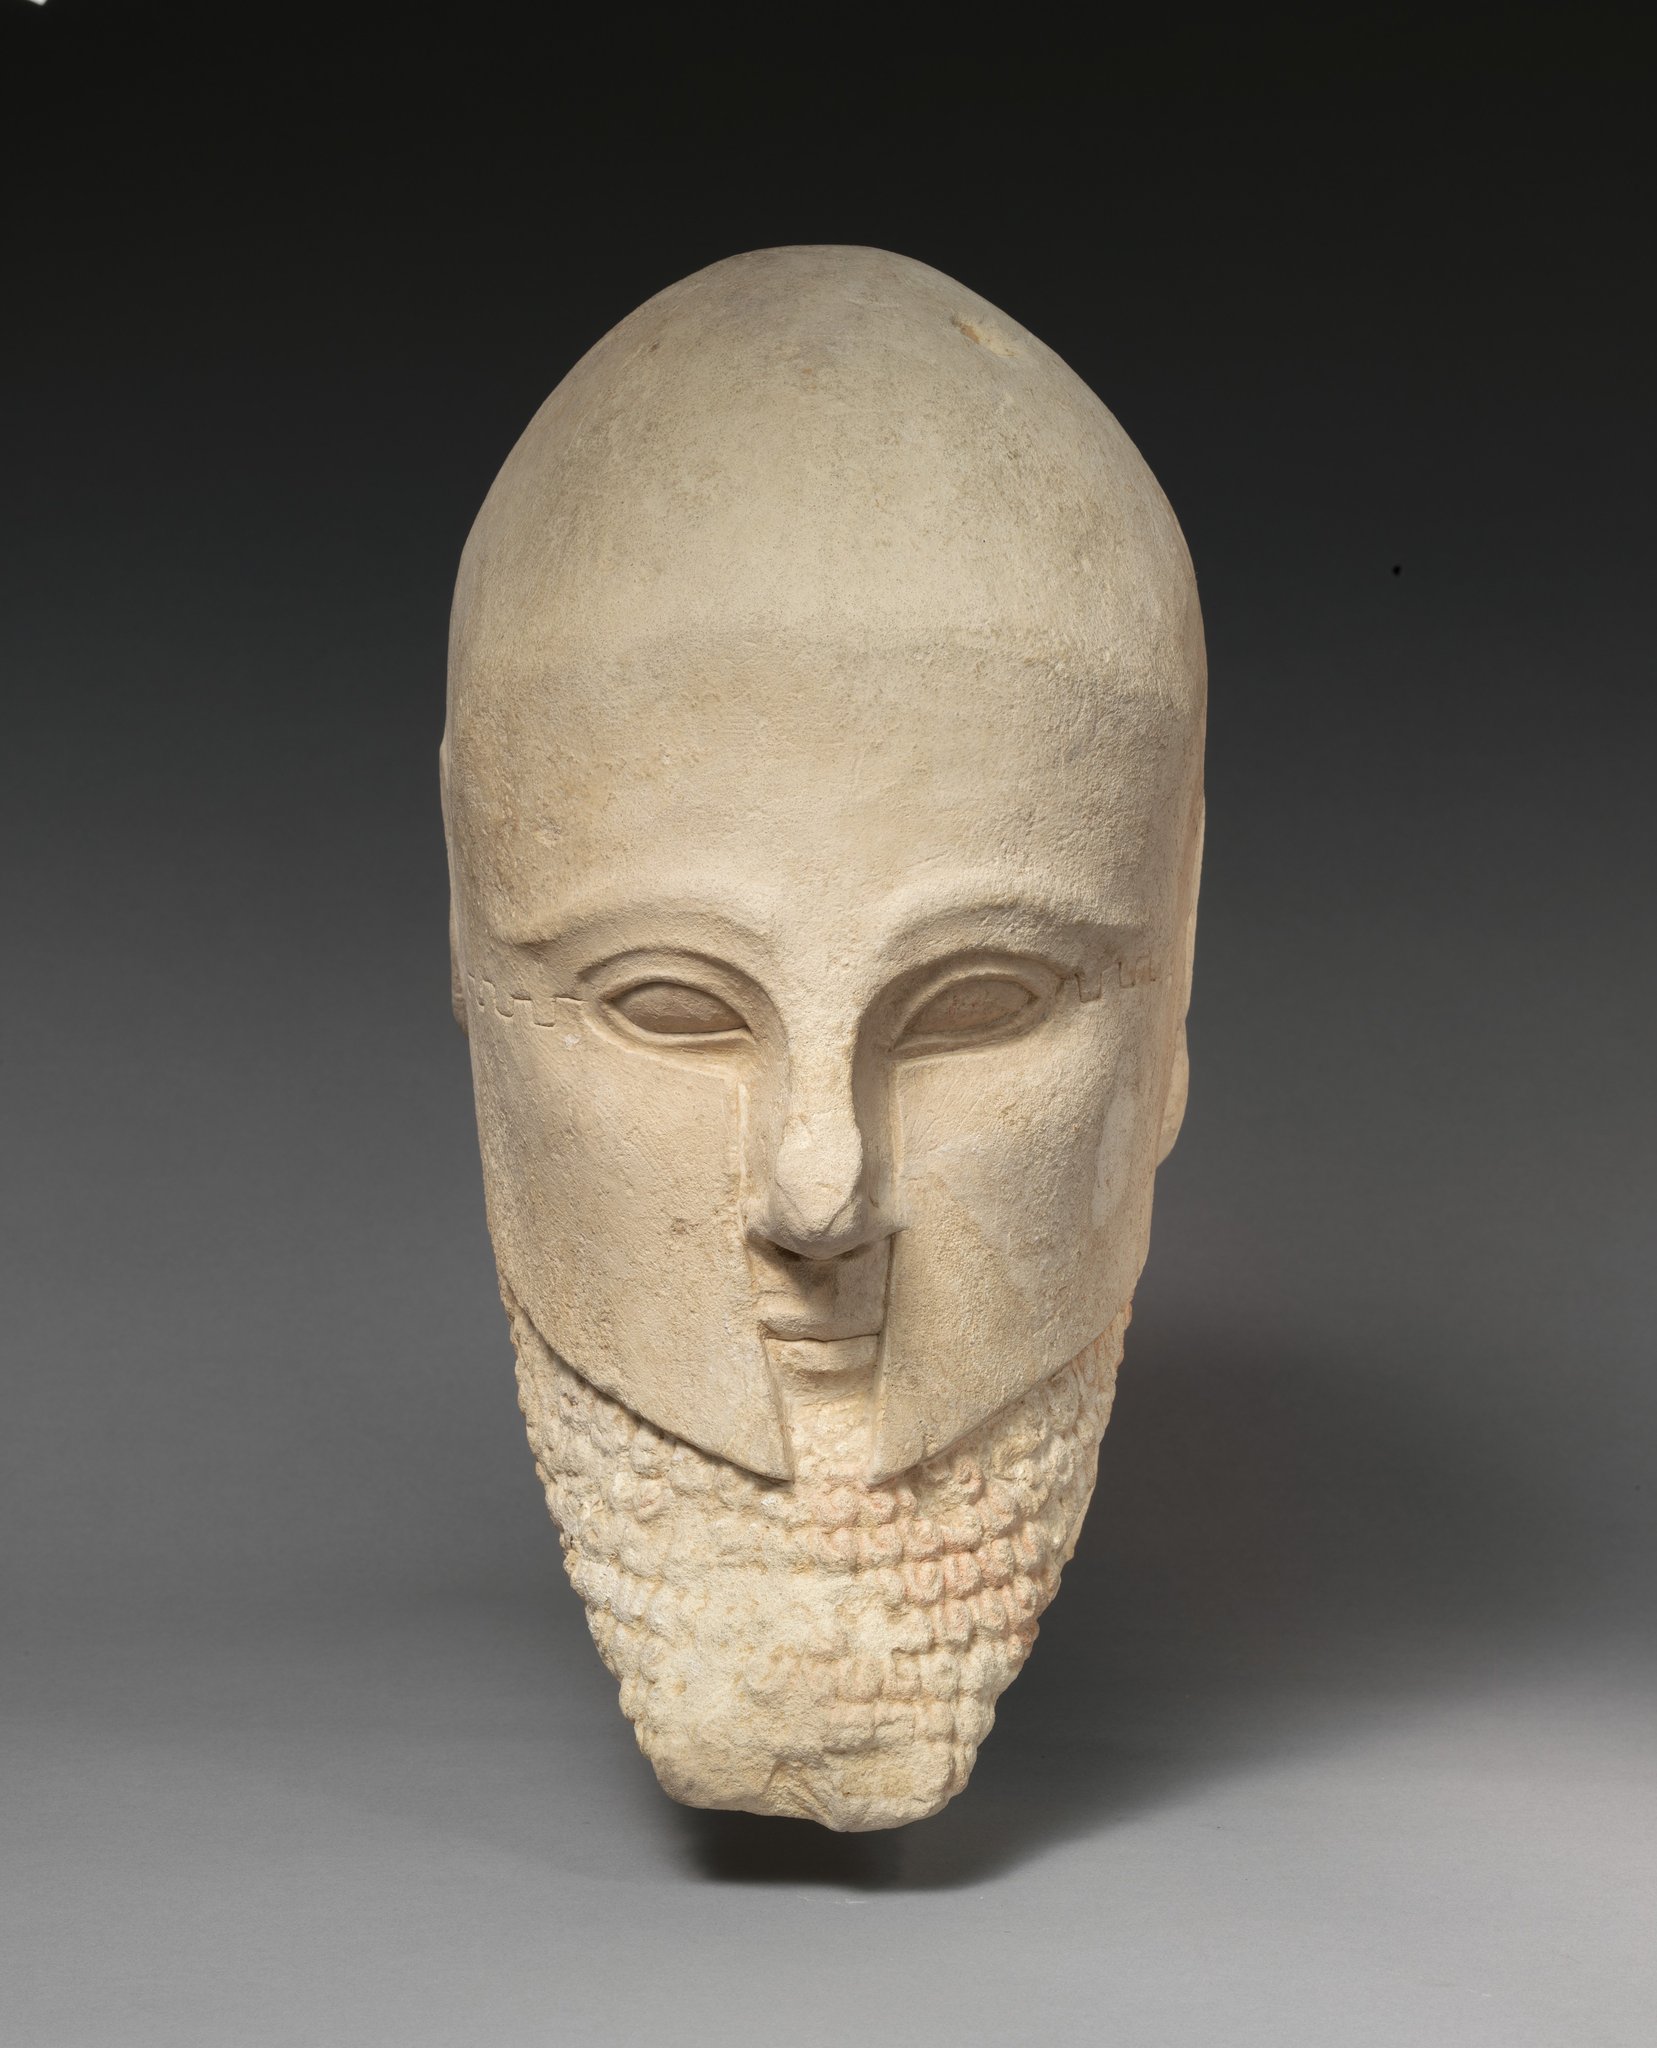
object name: male head, wearing a greek helmet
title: Limestone bearded head with a Corinthian helmet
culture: cypriot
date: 500-468 BCE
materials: limestone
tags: helmets,heads,men